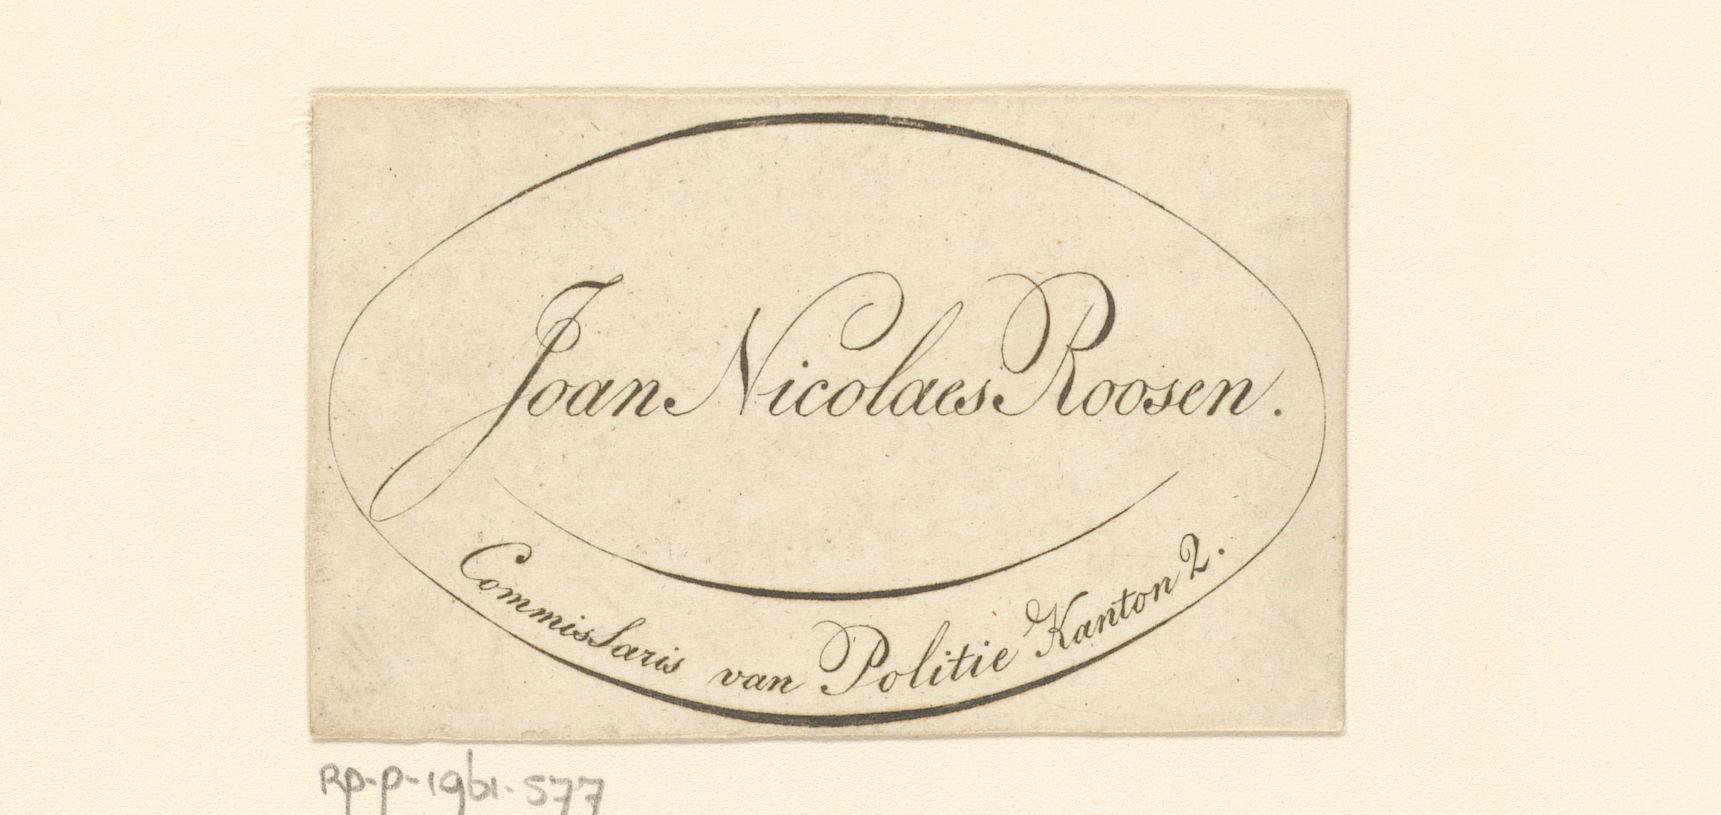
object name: business card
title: Adreskaart van politiecommissaris Joan Nicolaes Roosen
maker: Anonymous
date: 1750-1850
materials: paper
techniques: engraving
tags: fancy letters